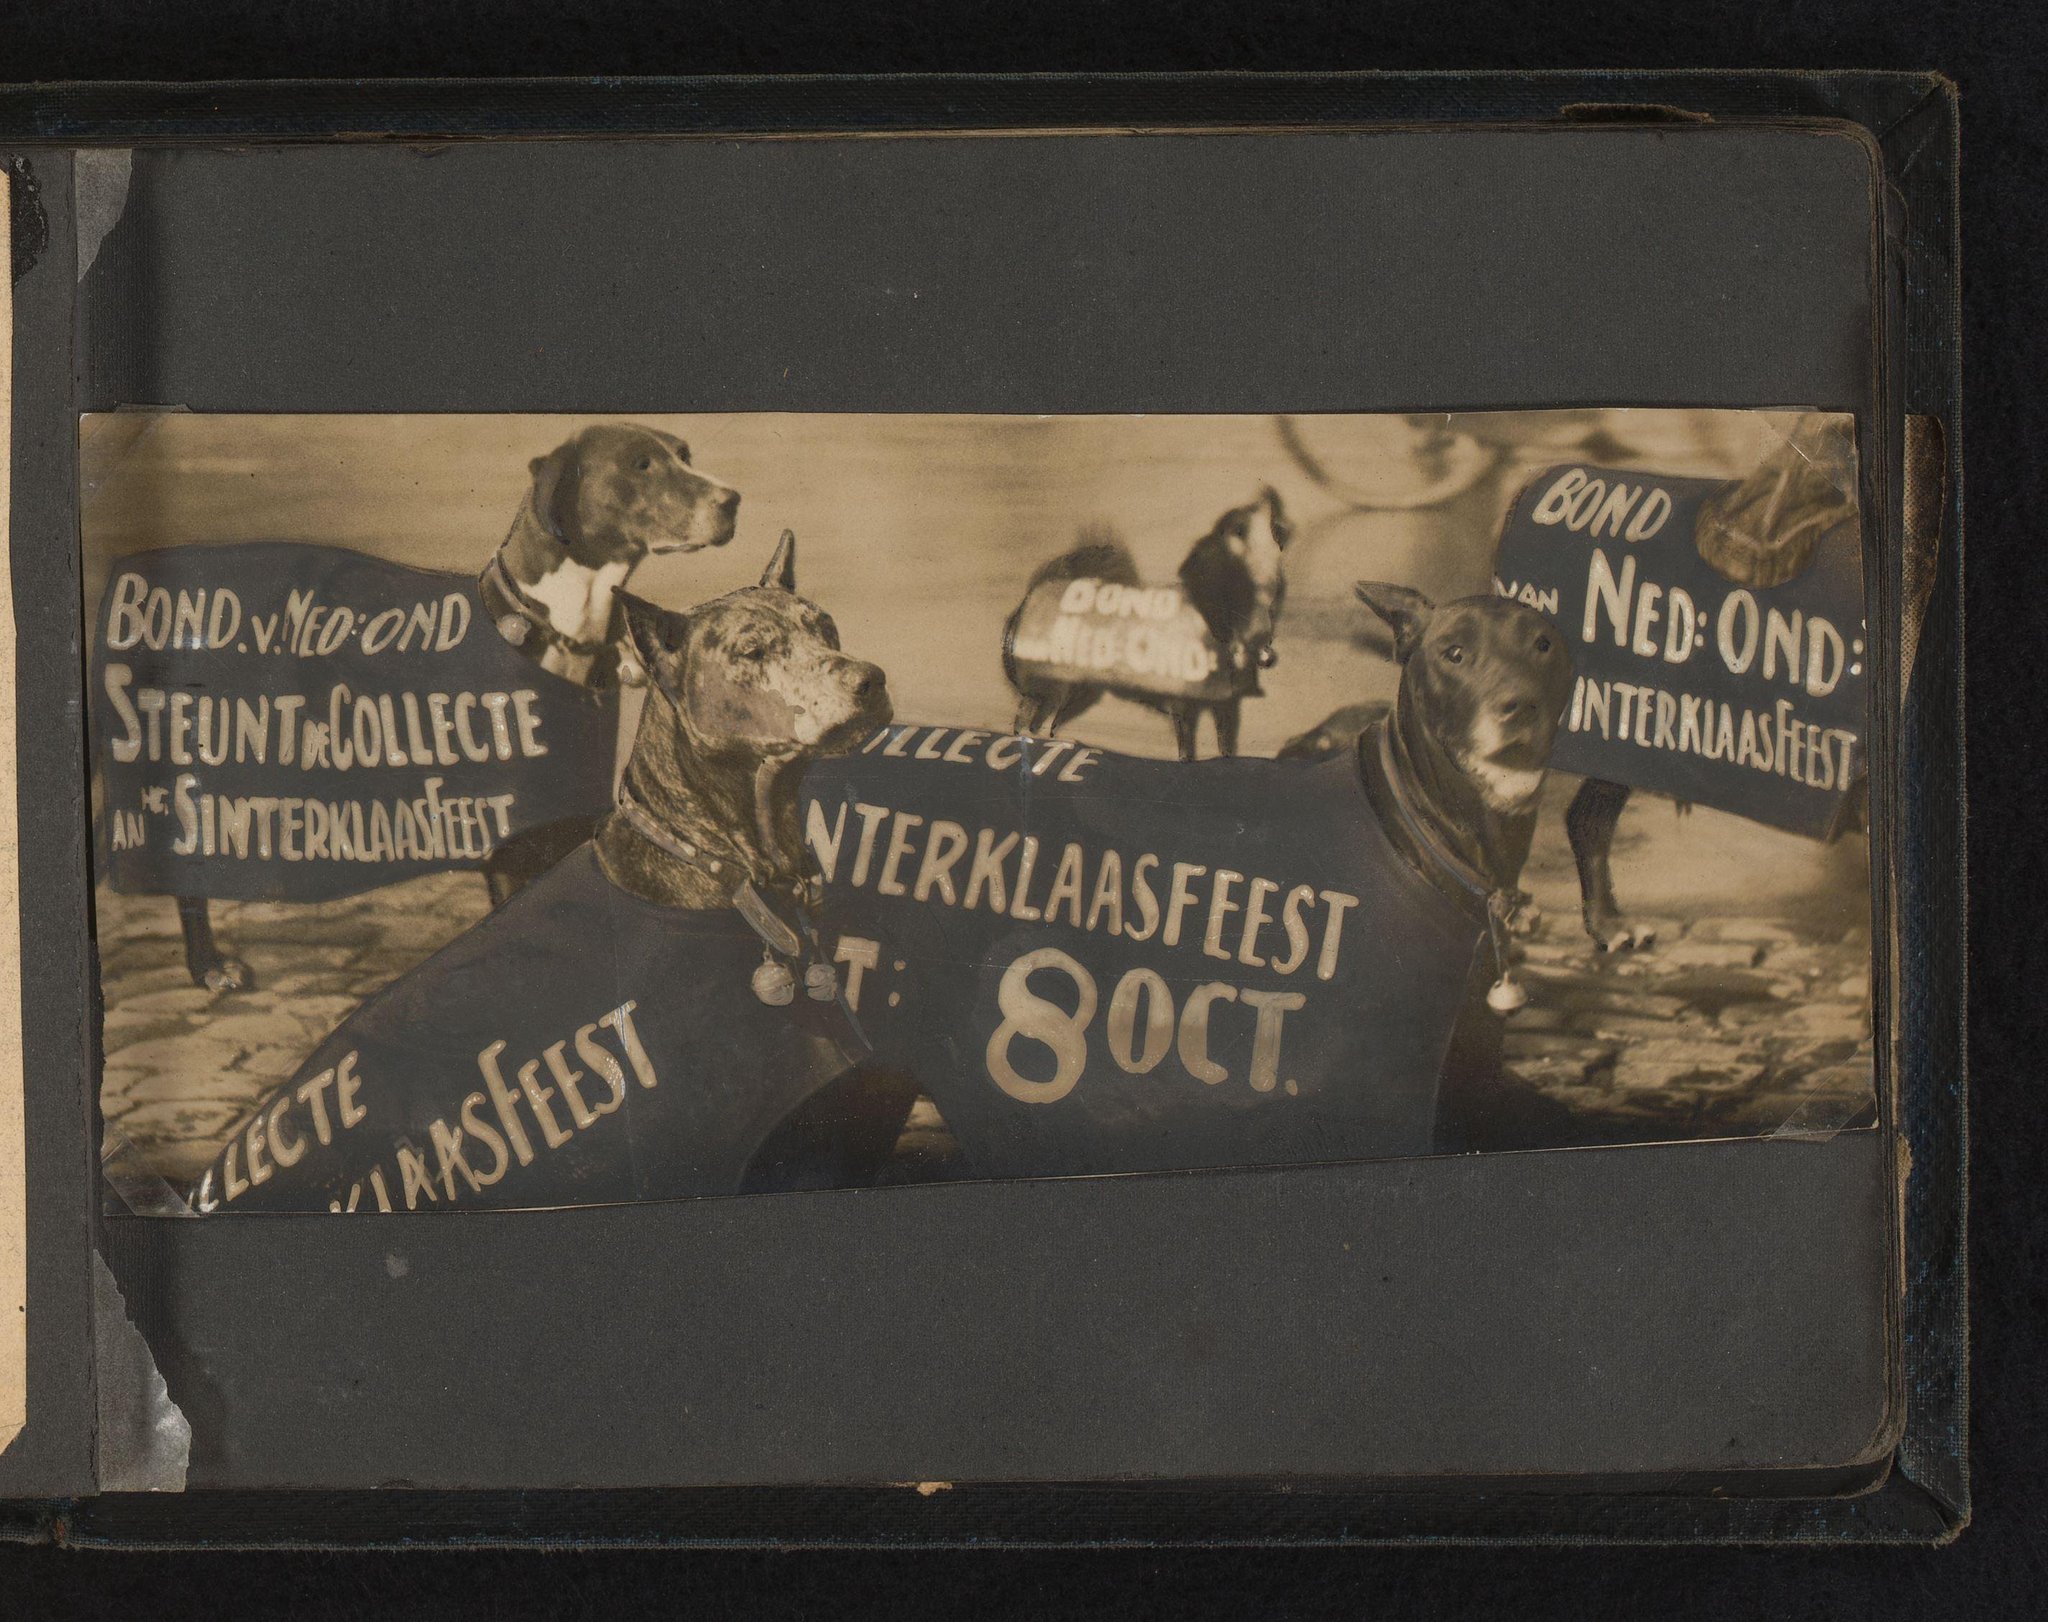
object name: photograph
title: Honden met reclameteksten voor Sinterklaasfeest van Bond van Nederlandse Ond.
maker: Anonymous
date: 1930-1940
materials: photographic support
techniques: gelatin silver print, hand coloring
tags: advertising, dog